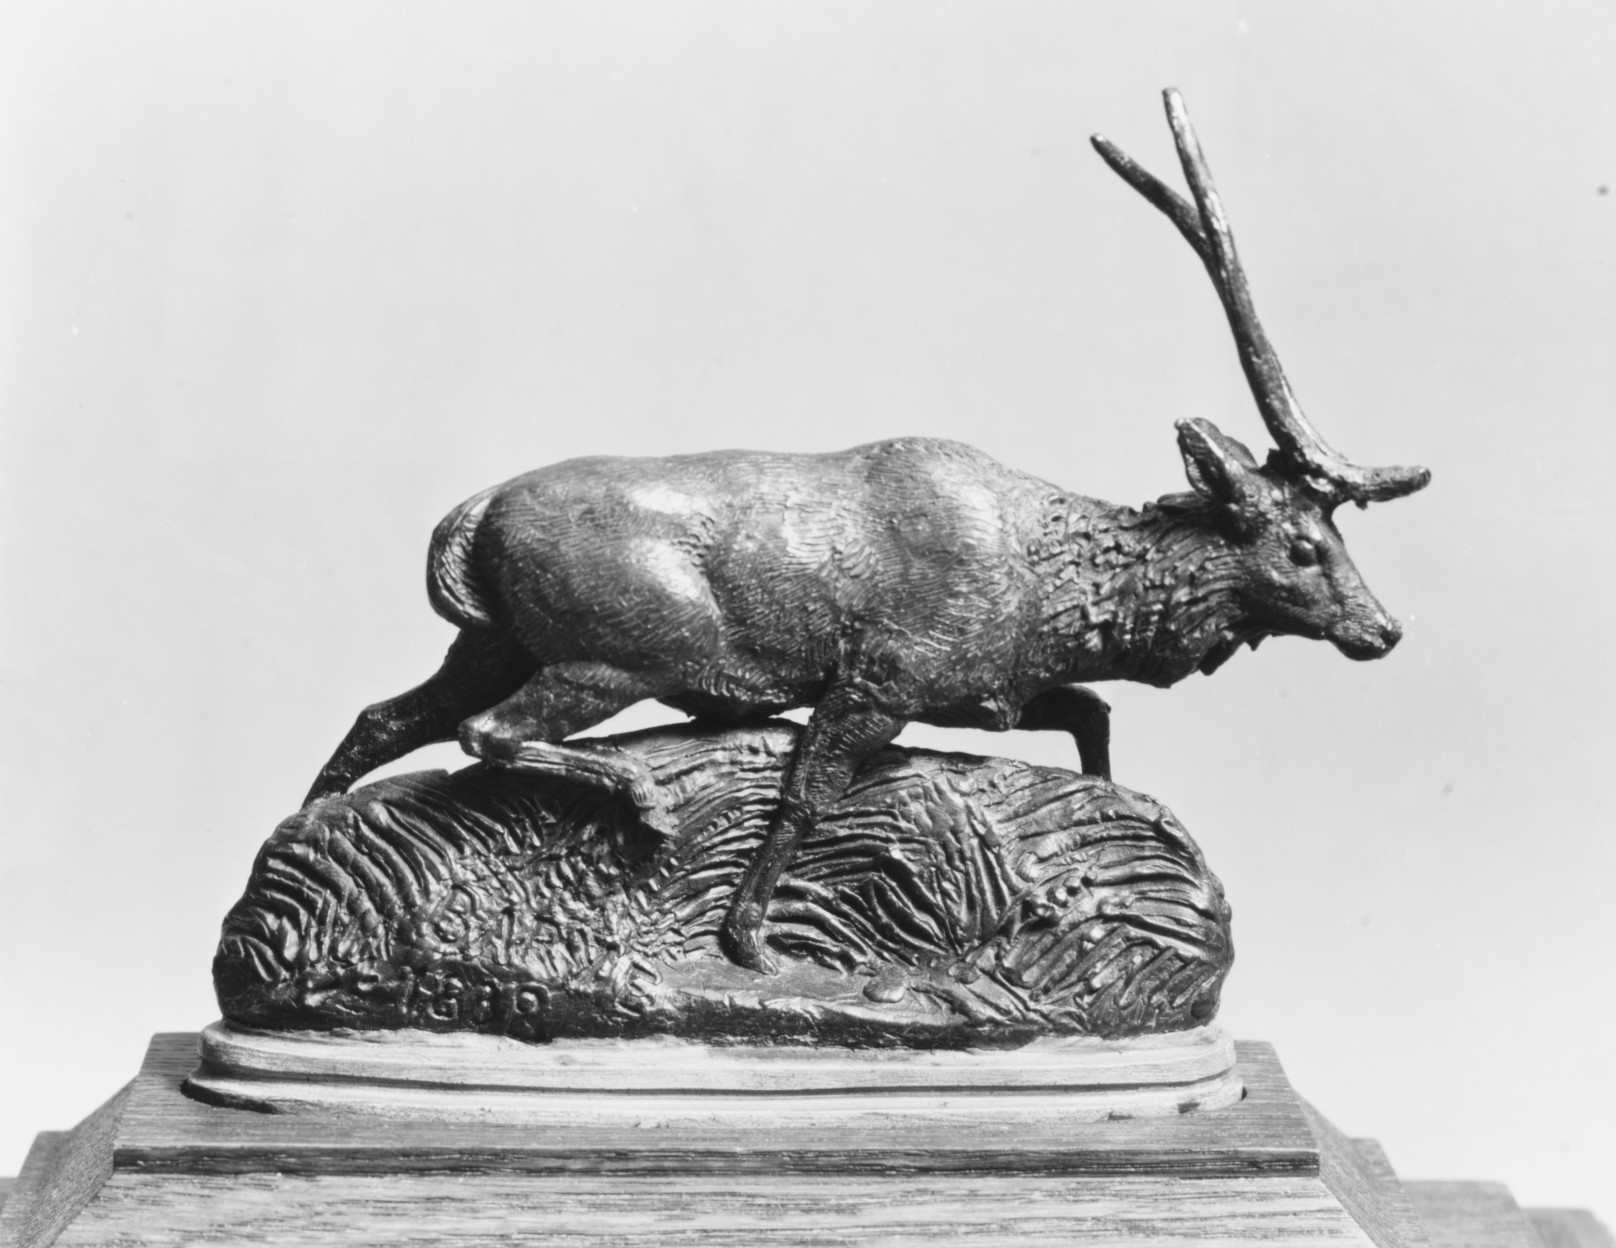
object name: statuette model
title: Java Deer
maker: antoine-louis barye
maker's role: artist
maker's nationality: french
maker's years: 1795-1875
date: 1838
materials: wax, wood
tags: deer